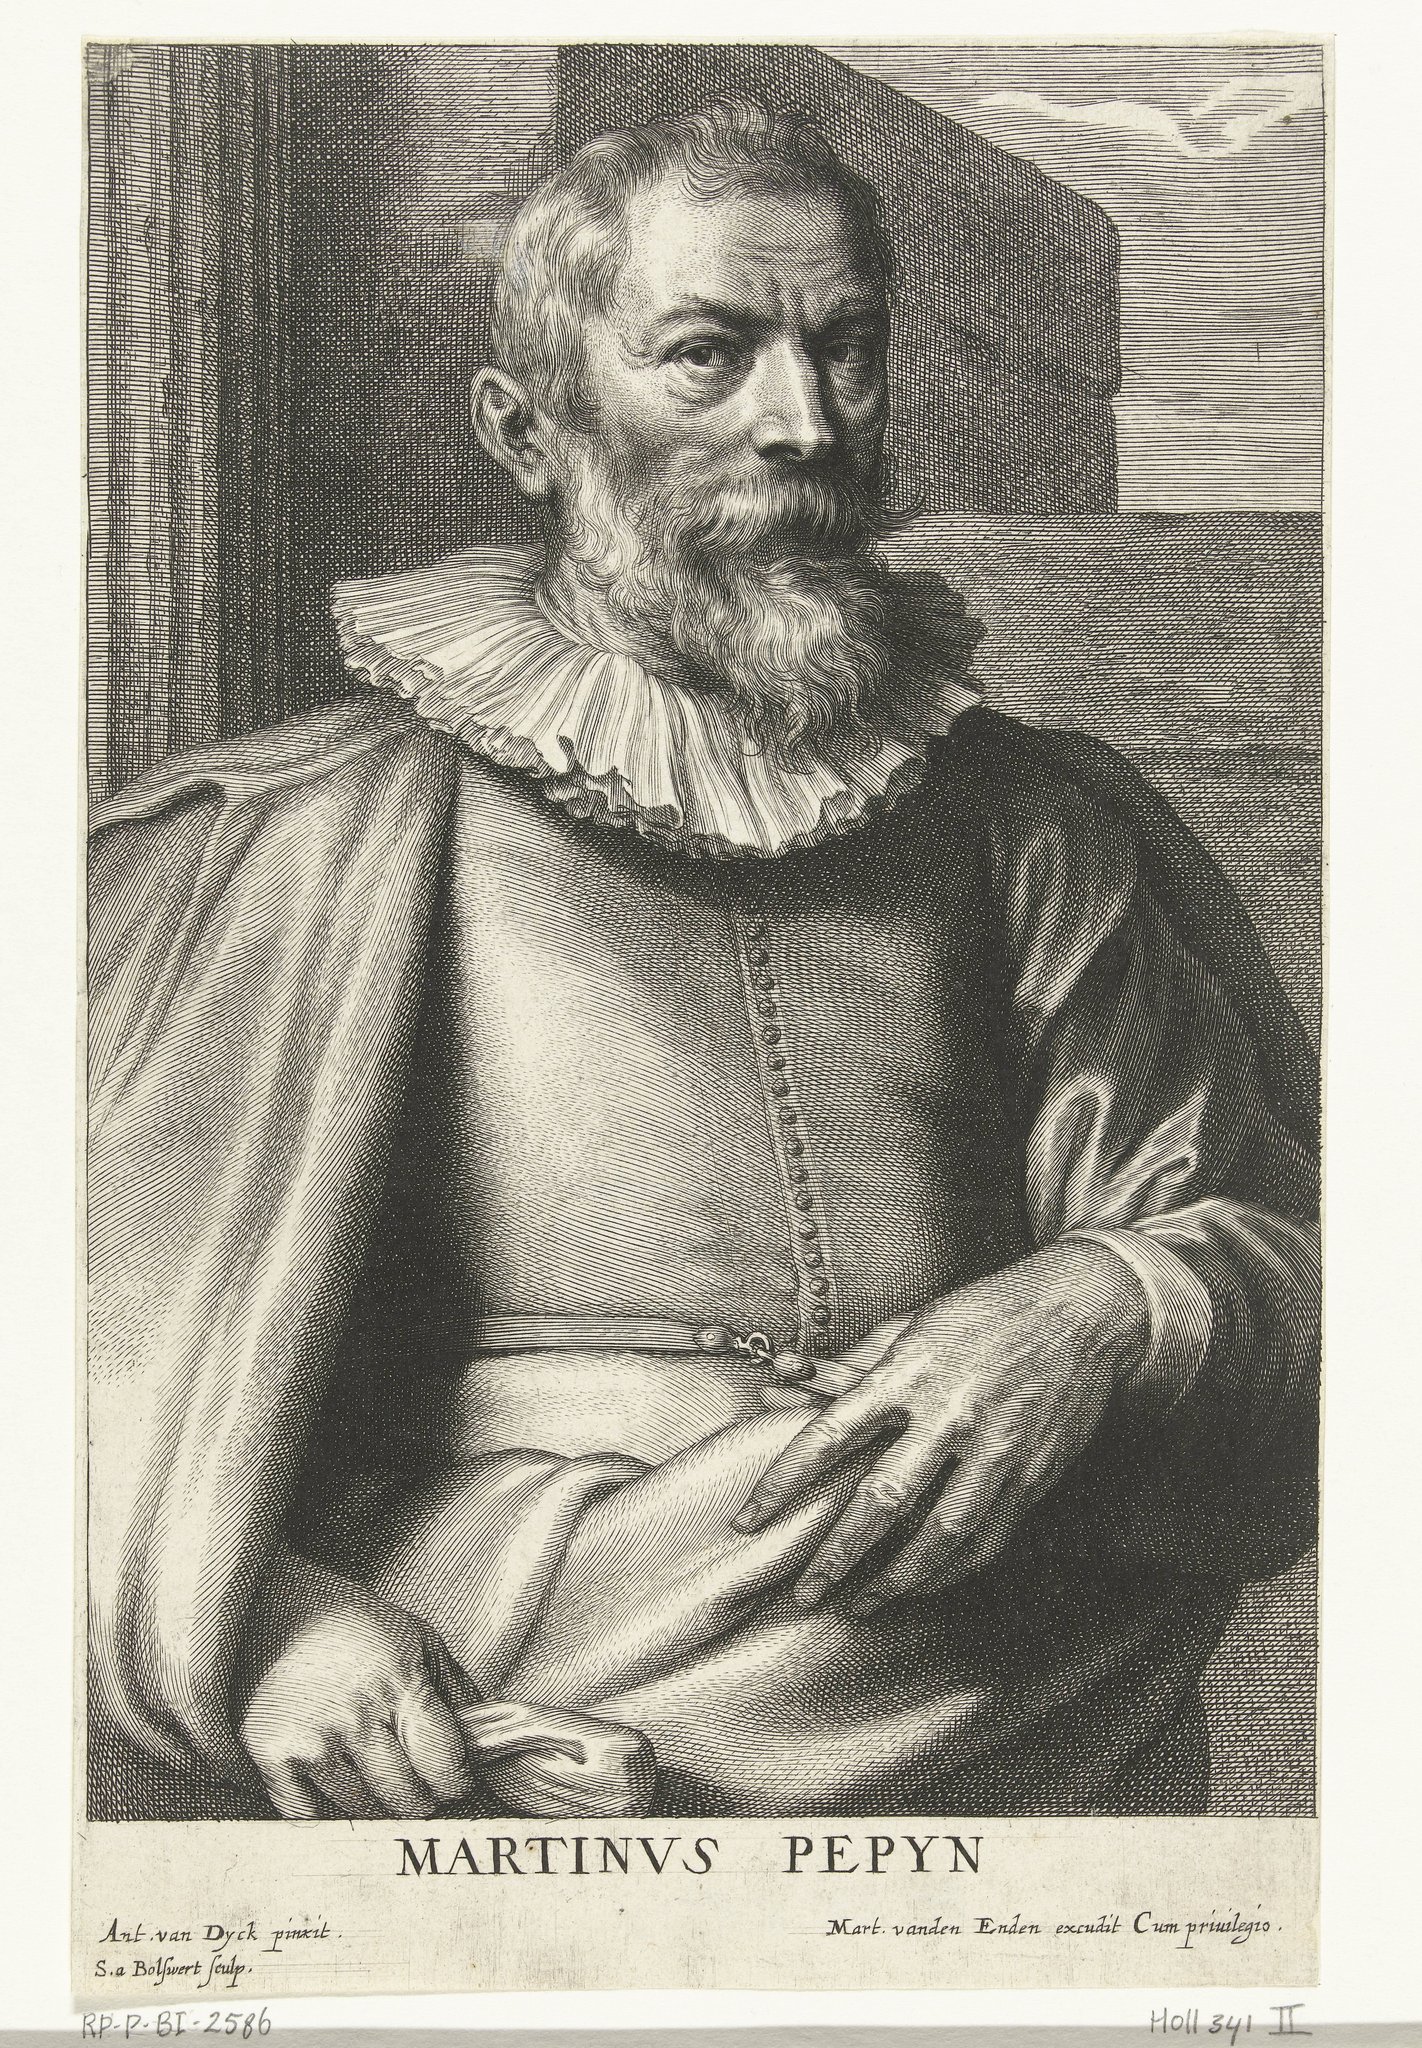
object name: print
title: Martinvs Pepyn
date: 1596-1659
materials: paper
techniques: engraving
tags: historical persons, portrait, self-portrait of painter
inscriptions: collector's mark: Lugt 240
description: Prent naar schilderij van Anthony van Dyck